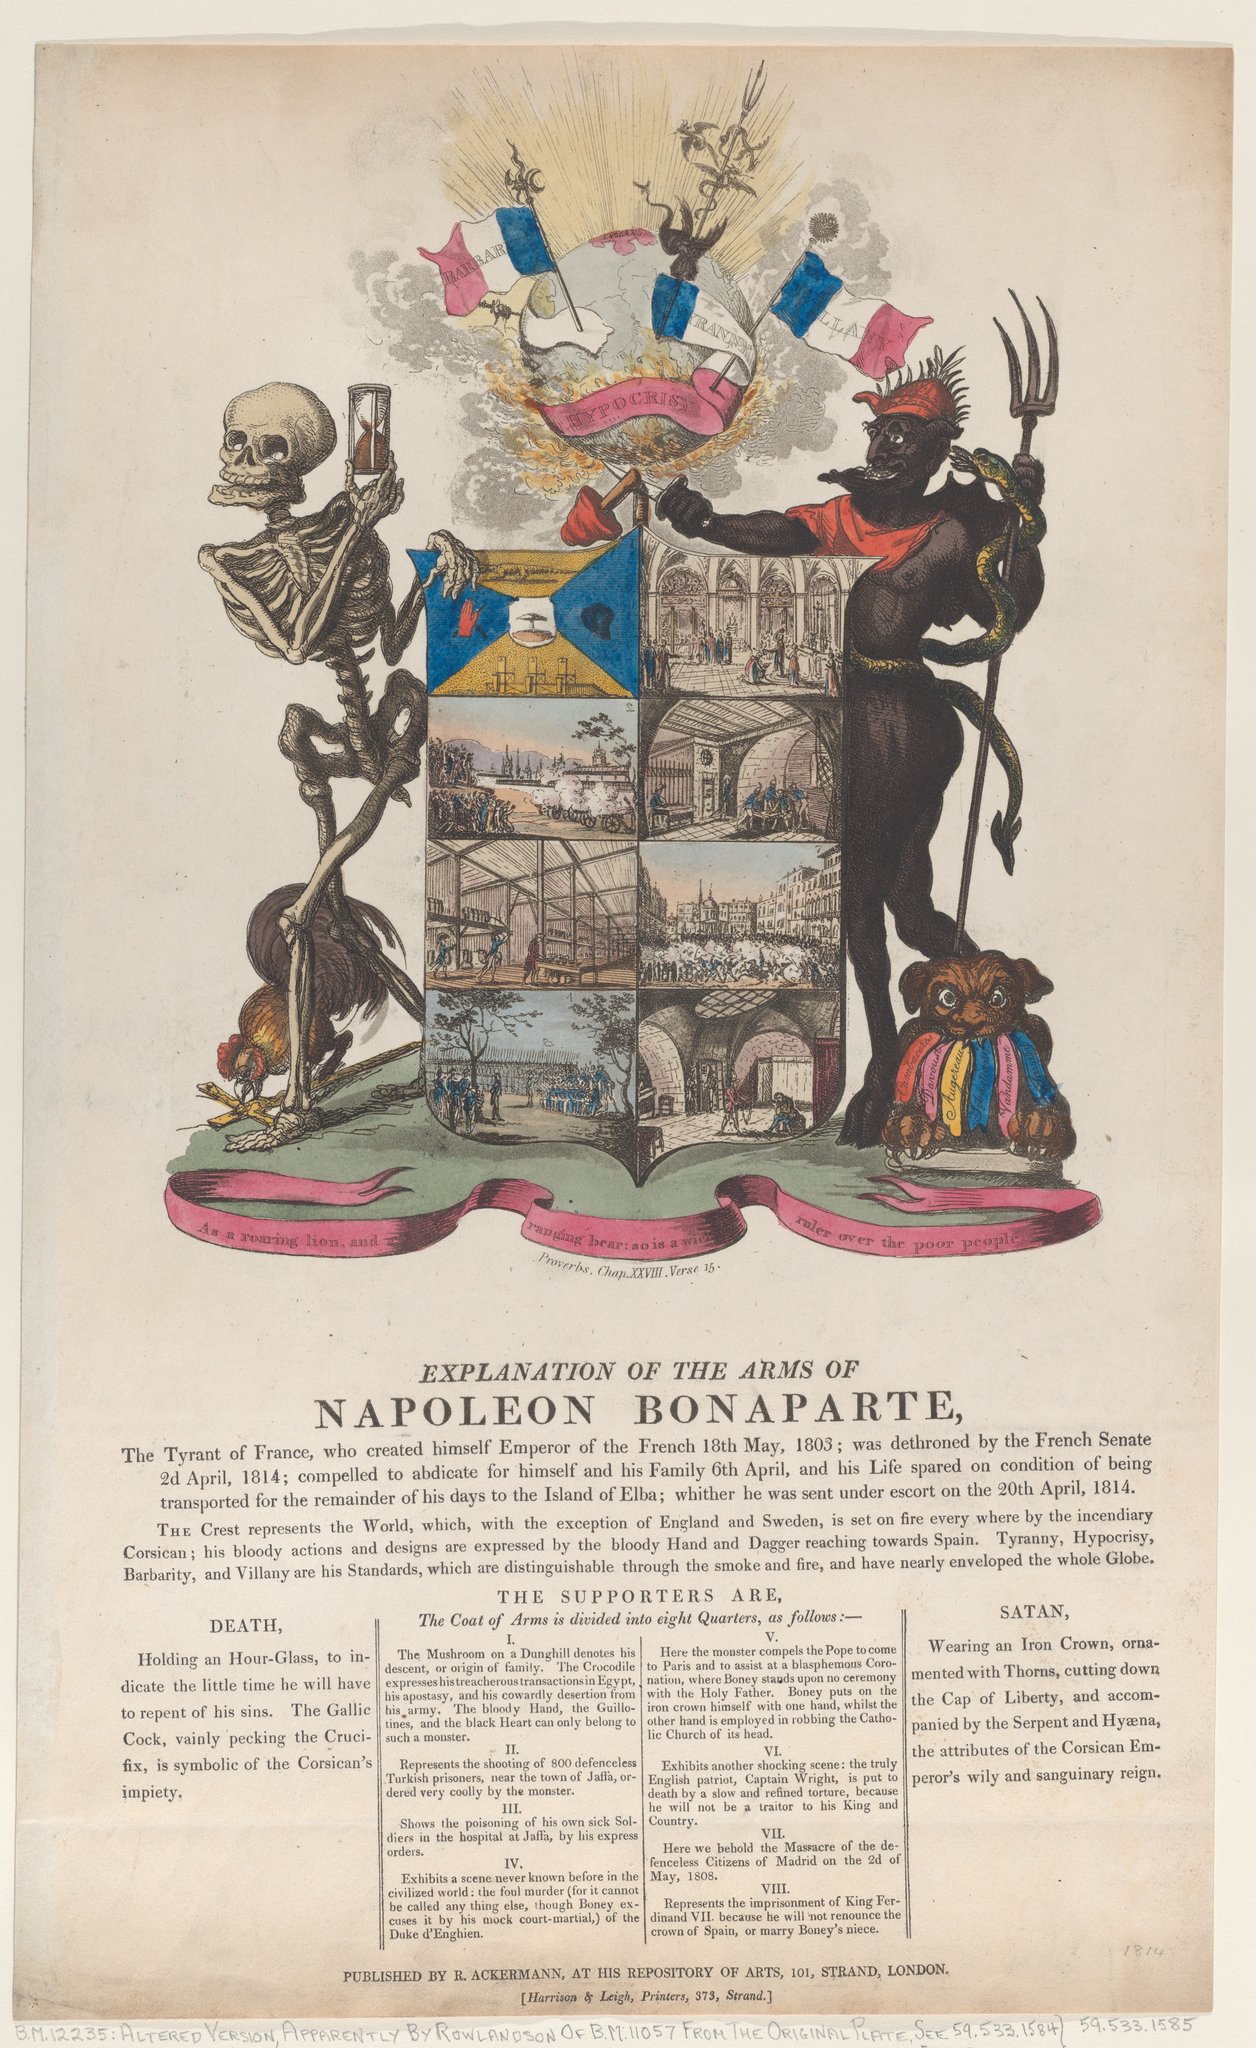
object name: print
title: Explanation of the Arms of Napoleon Bonaparte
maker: thomas rowlandson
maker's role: artist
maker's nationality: british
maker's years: 1757-1827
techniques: aquatint, etching, letterpress